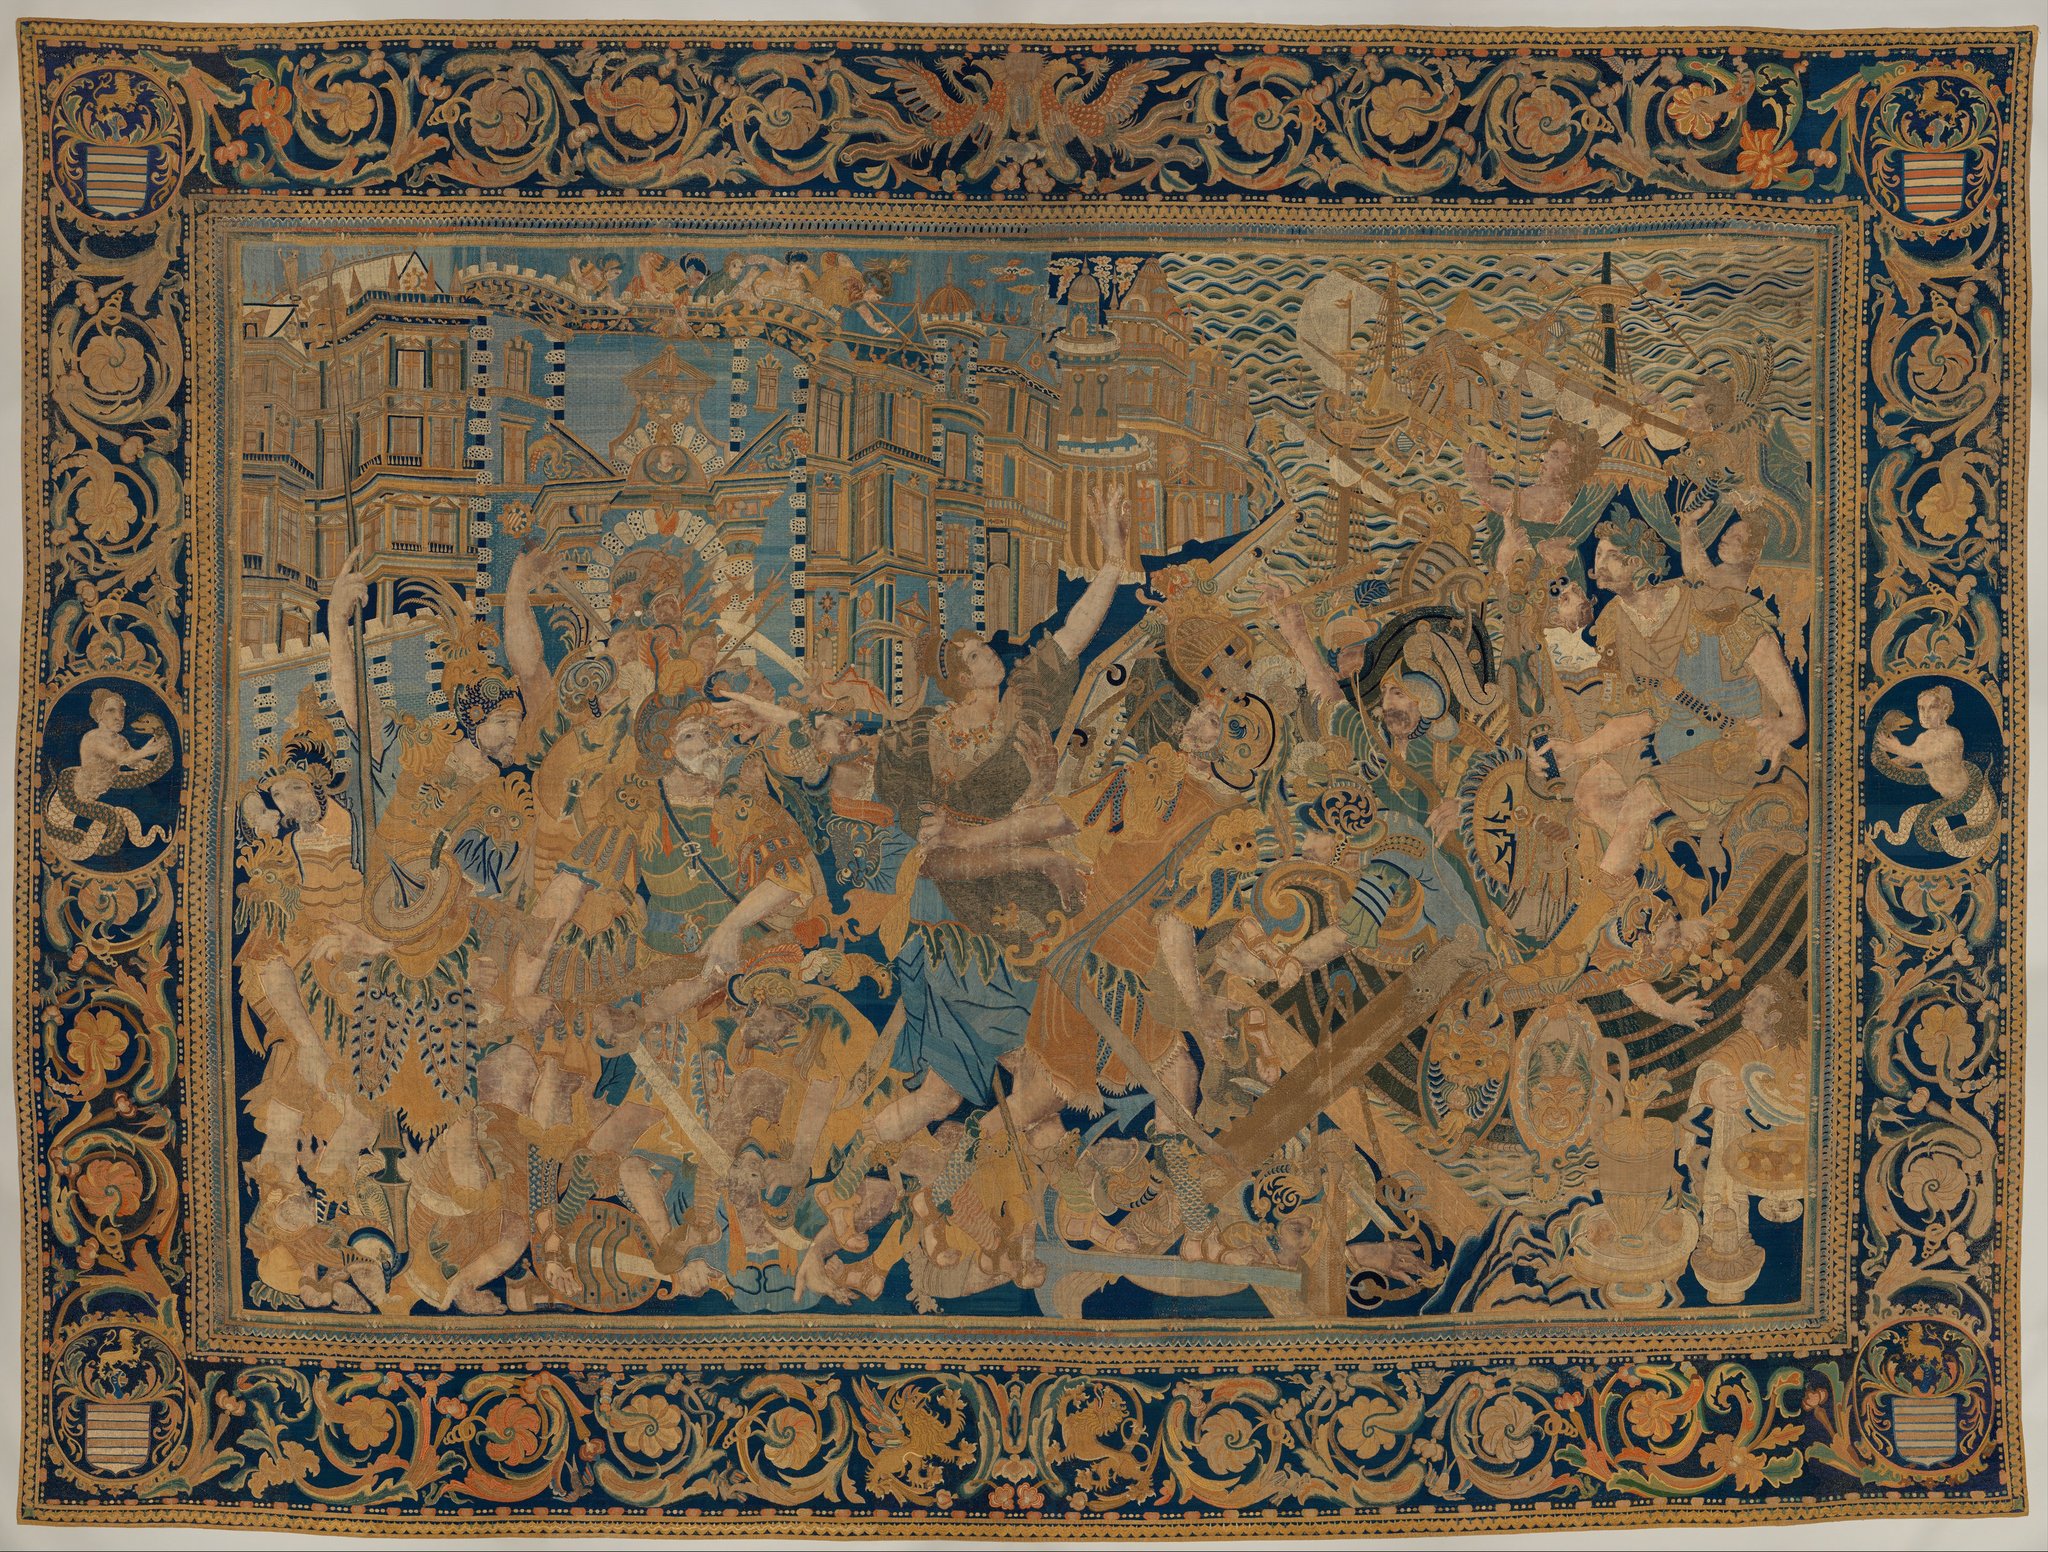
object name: hanging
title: The Abduction of Helen from a set of The Story of Troy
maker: bernard salomon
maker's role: artist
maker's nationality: french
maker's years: 1508-1561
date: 1625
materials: cotton, gilt, paper, pigment, silk, thread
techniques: embroidery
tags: soldiers,men,helen,coat of arms,ships